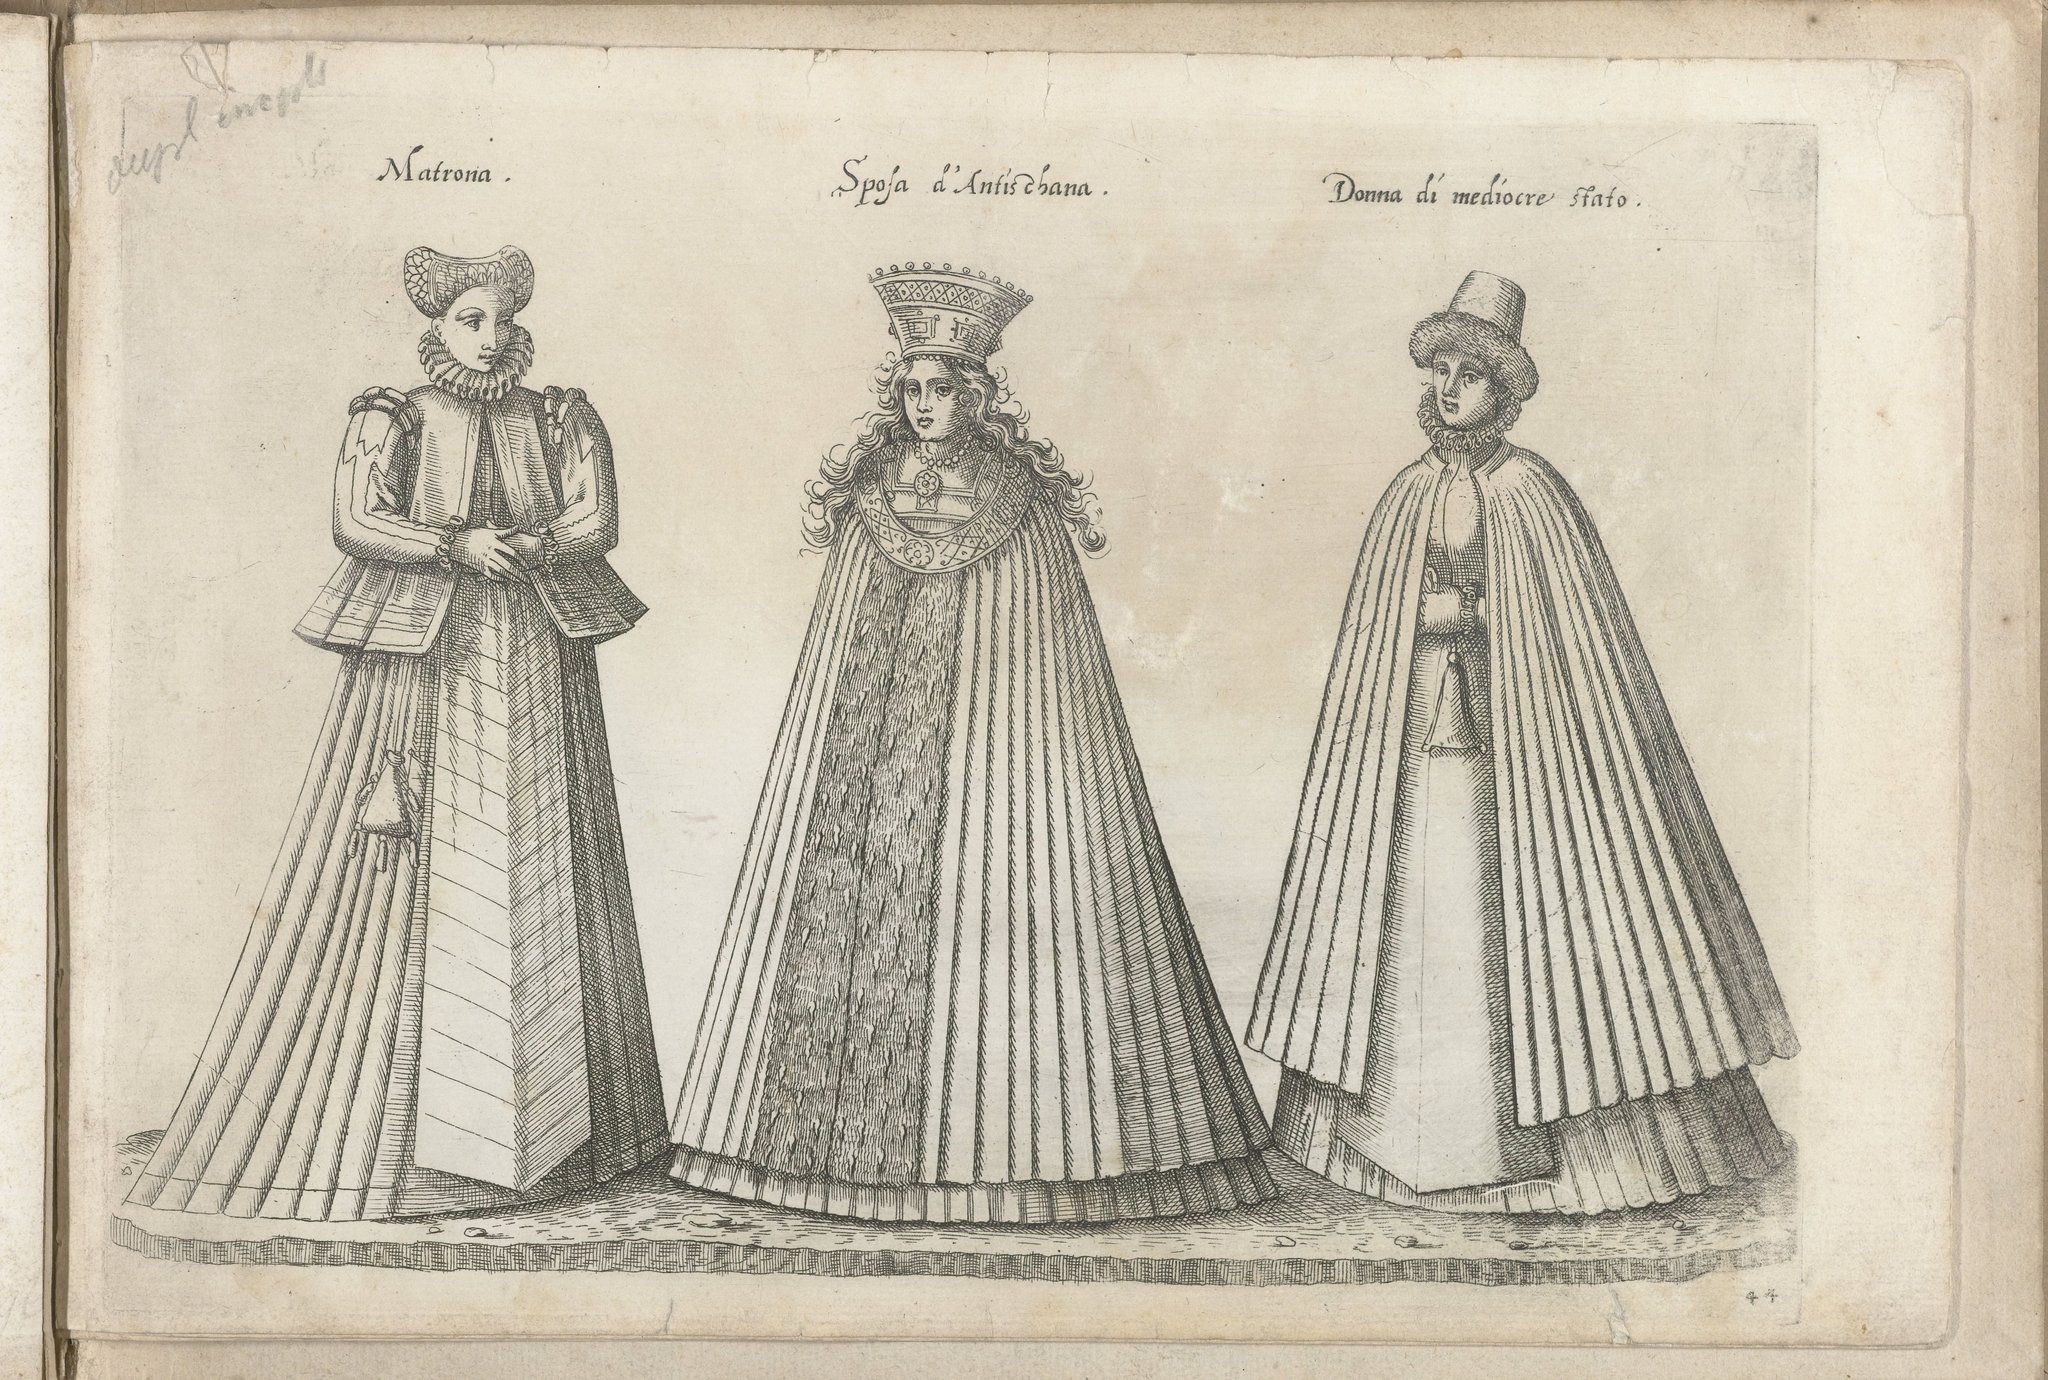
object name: costume print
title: Drie vrouwen van verschillende standen, gekleed volgens de Duitse mode van ca. 1580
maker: bartolomeo grassi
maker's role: publisher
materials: paper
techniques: engraving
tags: bride (in wedding-dress)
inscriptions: number: ‘43’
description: De middelste vrouw is een marketenster (naar Beham). Prent uit album 'Dei veri ritratti degl'habiti di tvtte le parti del mondo intagliati in rame per opra di Bartolomeo Grassi', 1585.